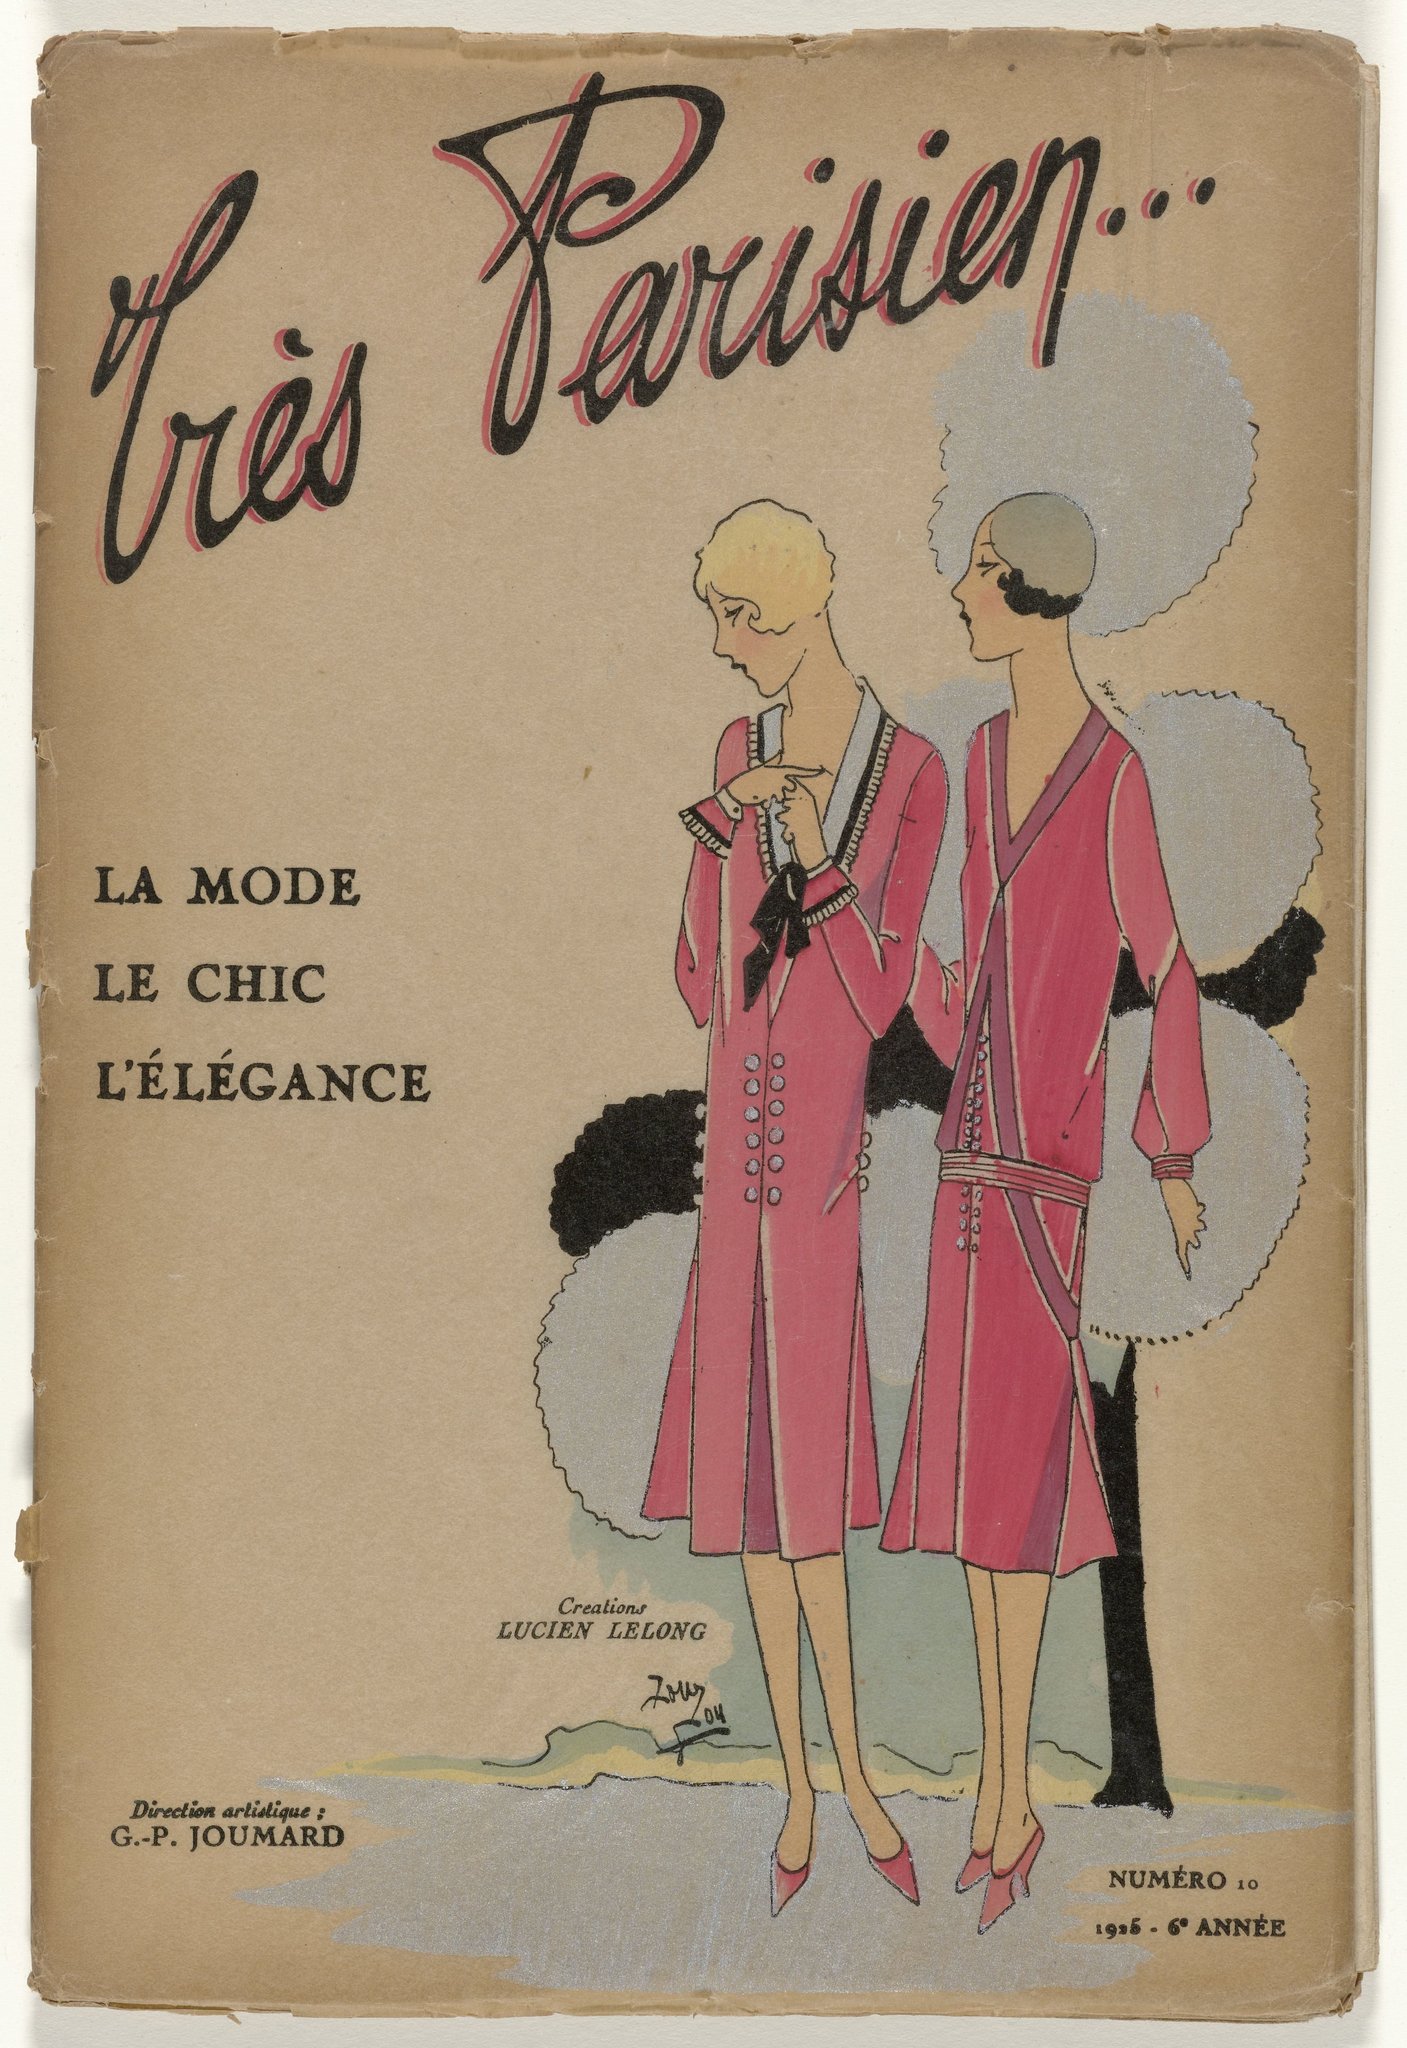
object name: magazine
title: Très Parisien (...)La Mode Le Chic L'Élégance 1925, Numéro 10, 1925-6e Année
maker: g-p. joumard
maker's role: publisher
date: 1925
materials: paper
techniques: letterpress printing, pochoir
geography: paris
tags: dress, gown: day dress (+ women's clothes), fashion plates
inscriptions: address: ‘Direction artistique: G.-P. Joumard’, title: ‘Très Parisien...La Mode Le Chic L'Élégance 1925, Numéro 10, 1925-6e Année’, : ‘Créations Lucien Lelong’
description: Très Parisien: acht pagina's tekst in boekdruk met afbeeldingen over nieuwe mode-ideeënen. 18 prenten met modellen in pochoir techniek, vijf pagina's met gedetailleerde schetsen en beschrijvingen van de getoonde ontwerpen en drie pagina's advertenties. In omslag in pochoir techniek. (Creaties van Lucien Lelong)